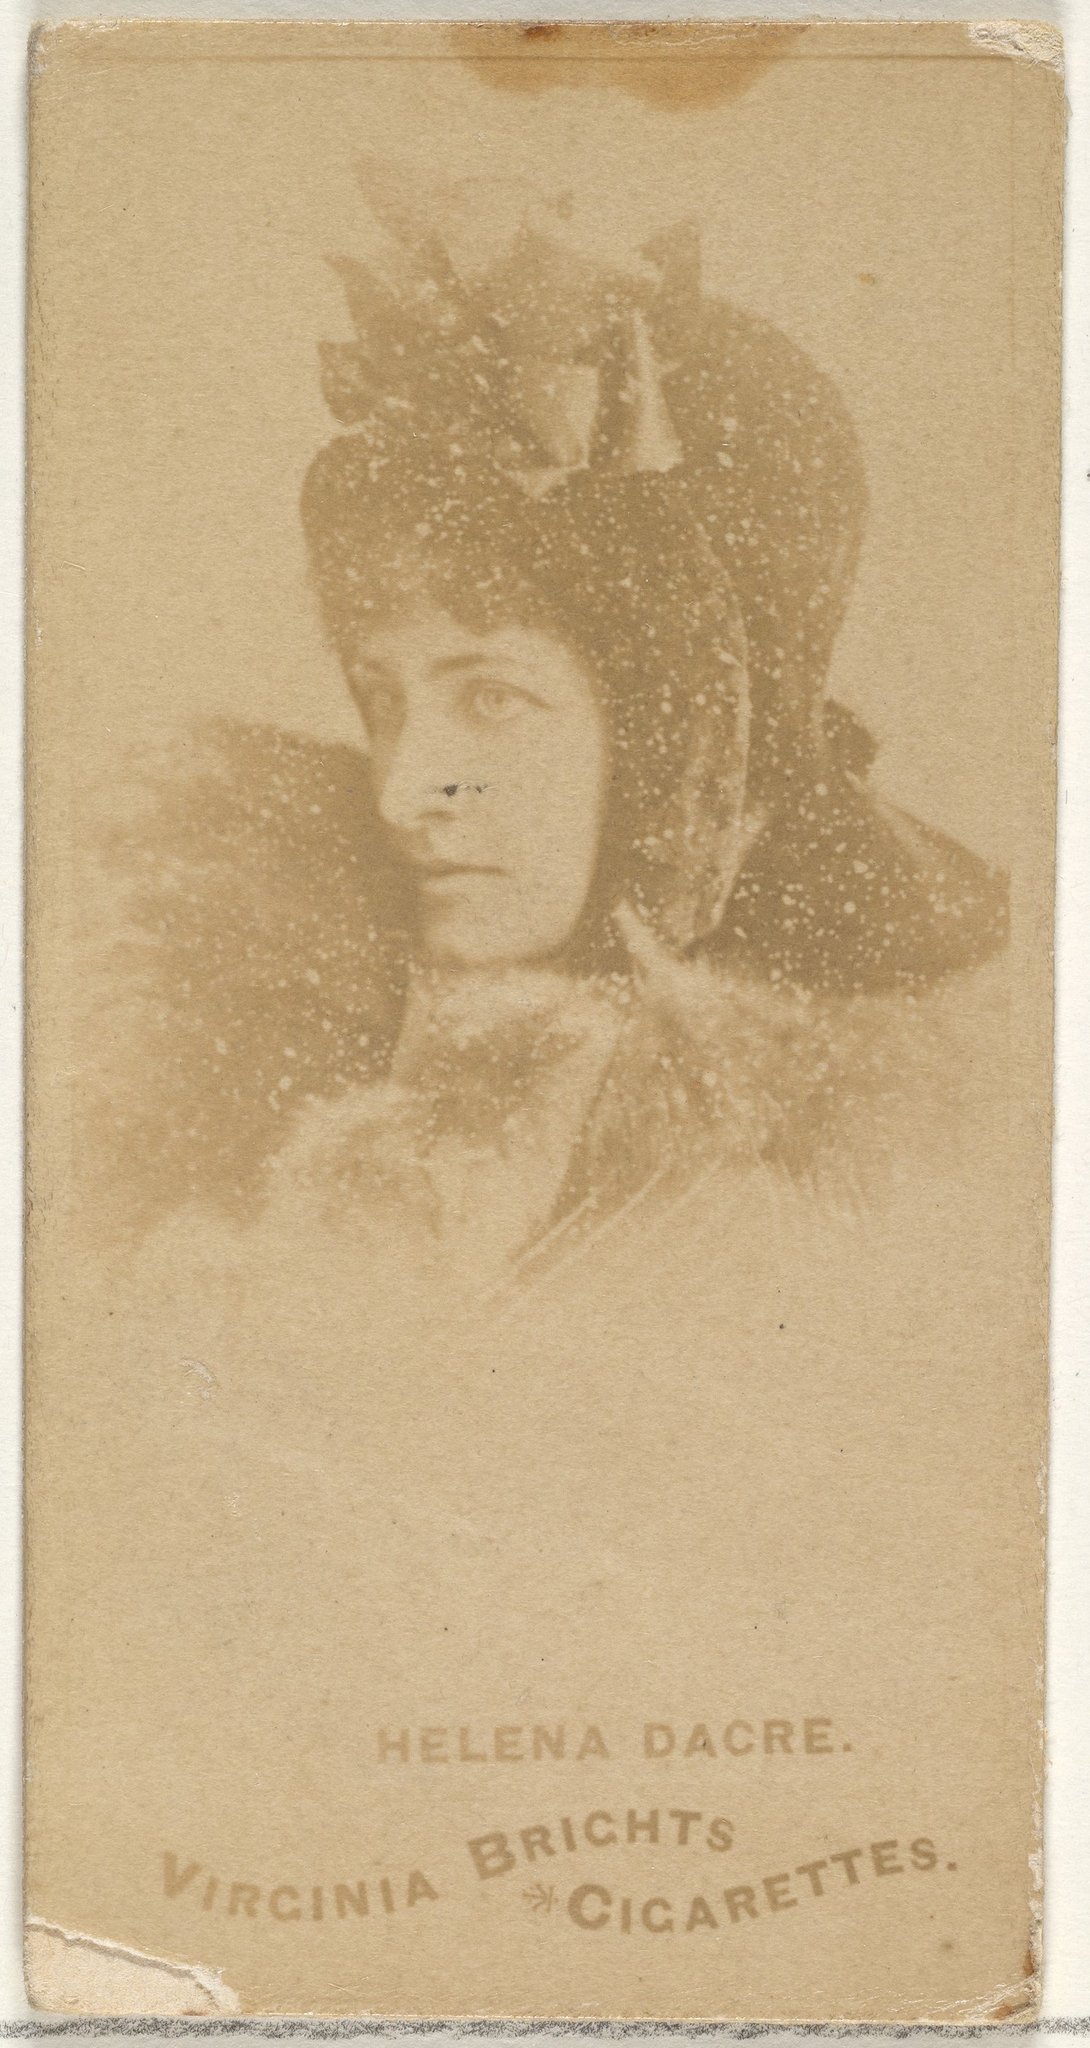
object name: photograph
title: Helena Dacre, from the Actors and Actresses series (N45, Type 1) for Virginia Brights Cigarettes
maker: allen & ginter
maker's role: publisher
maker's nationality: american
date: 1888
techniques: albumen silver print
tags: portraits,women,actresses